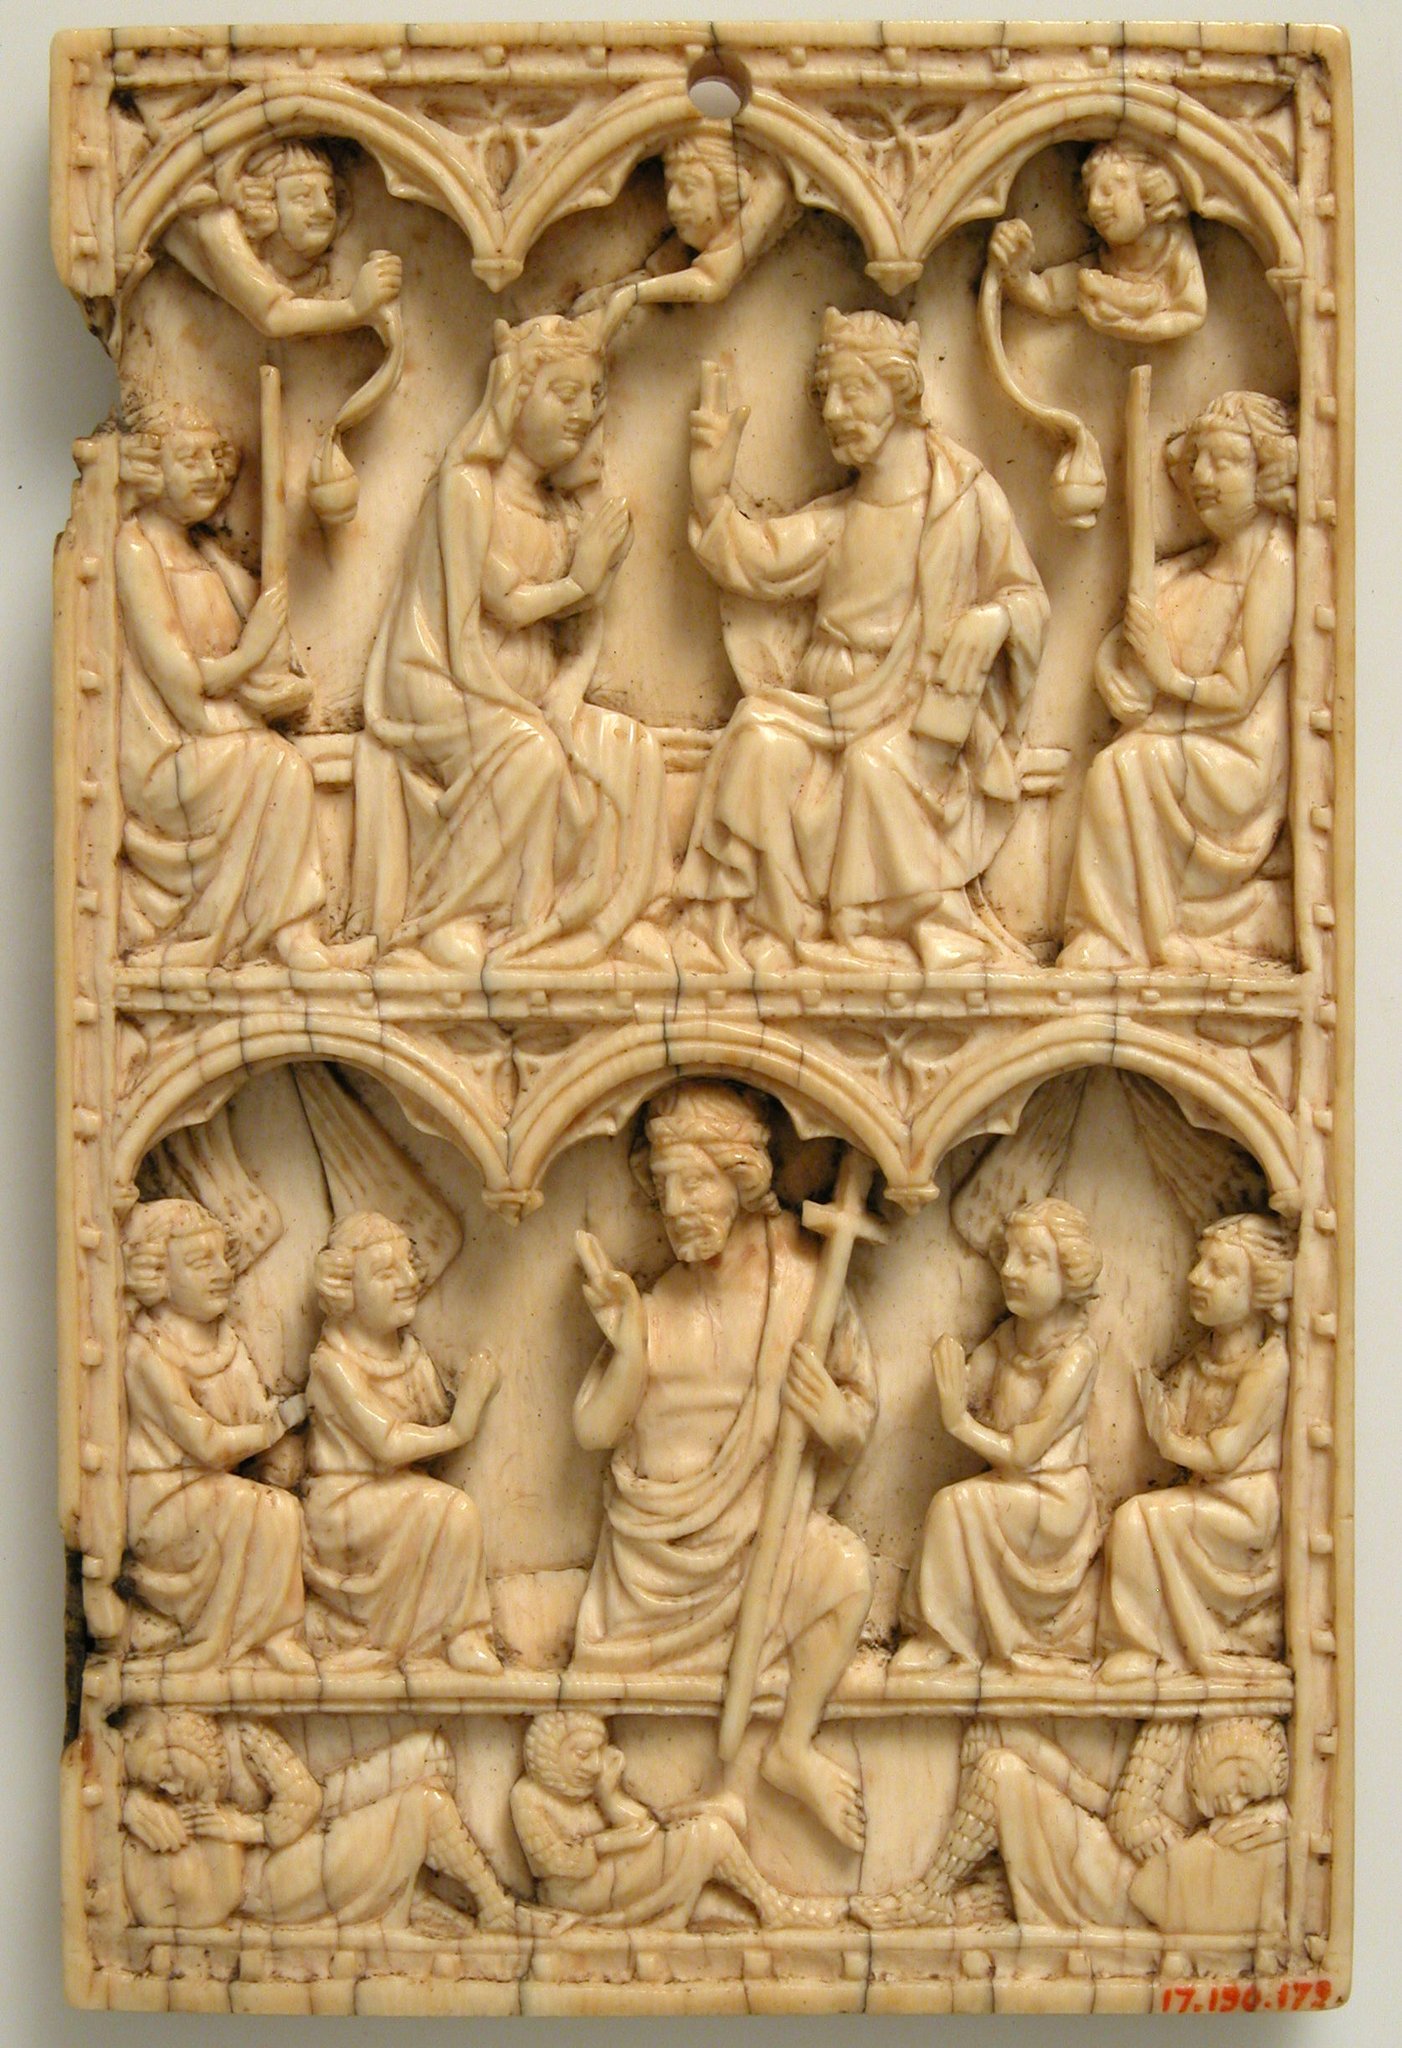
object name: diptych leaf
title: Diptych Leaf with the Resurrection and the Coronation of the Virgin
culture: french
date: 1340-1360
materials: ivory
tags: women,christ,cross